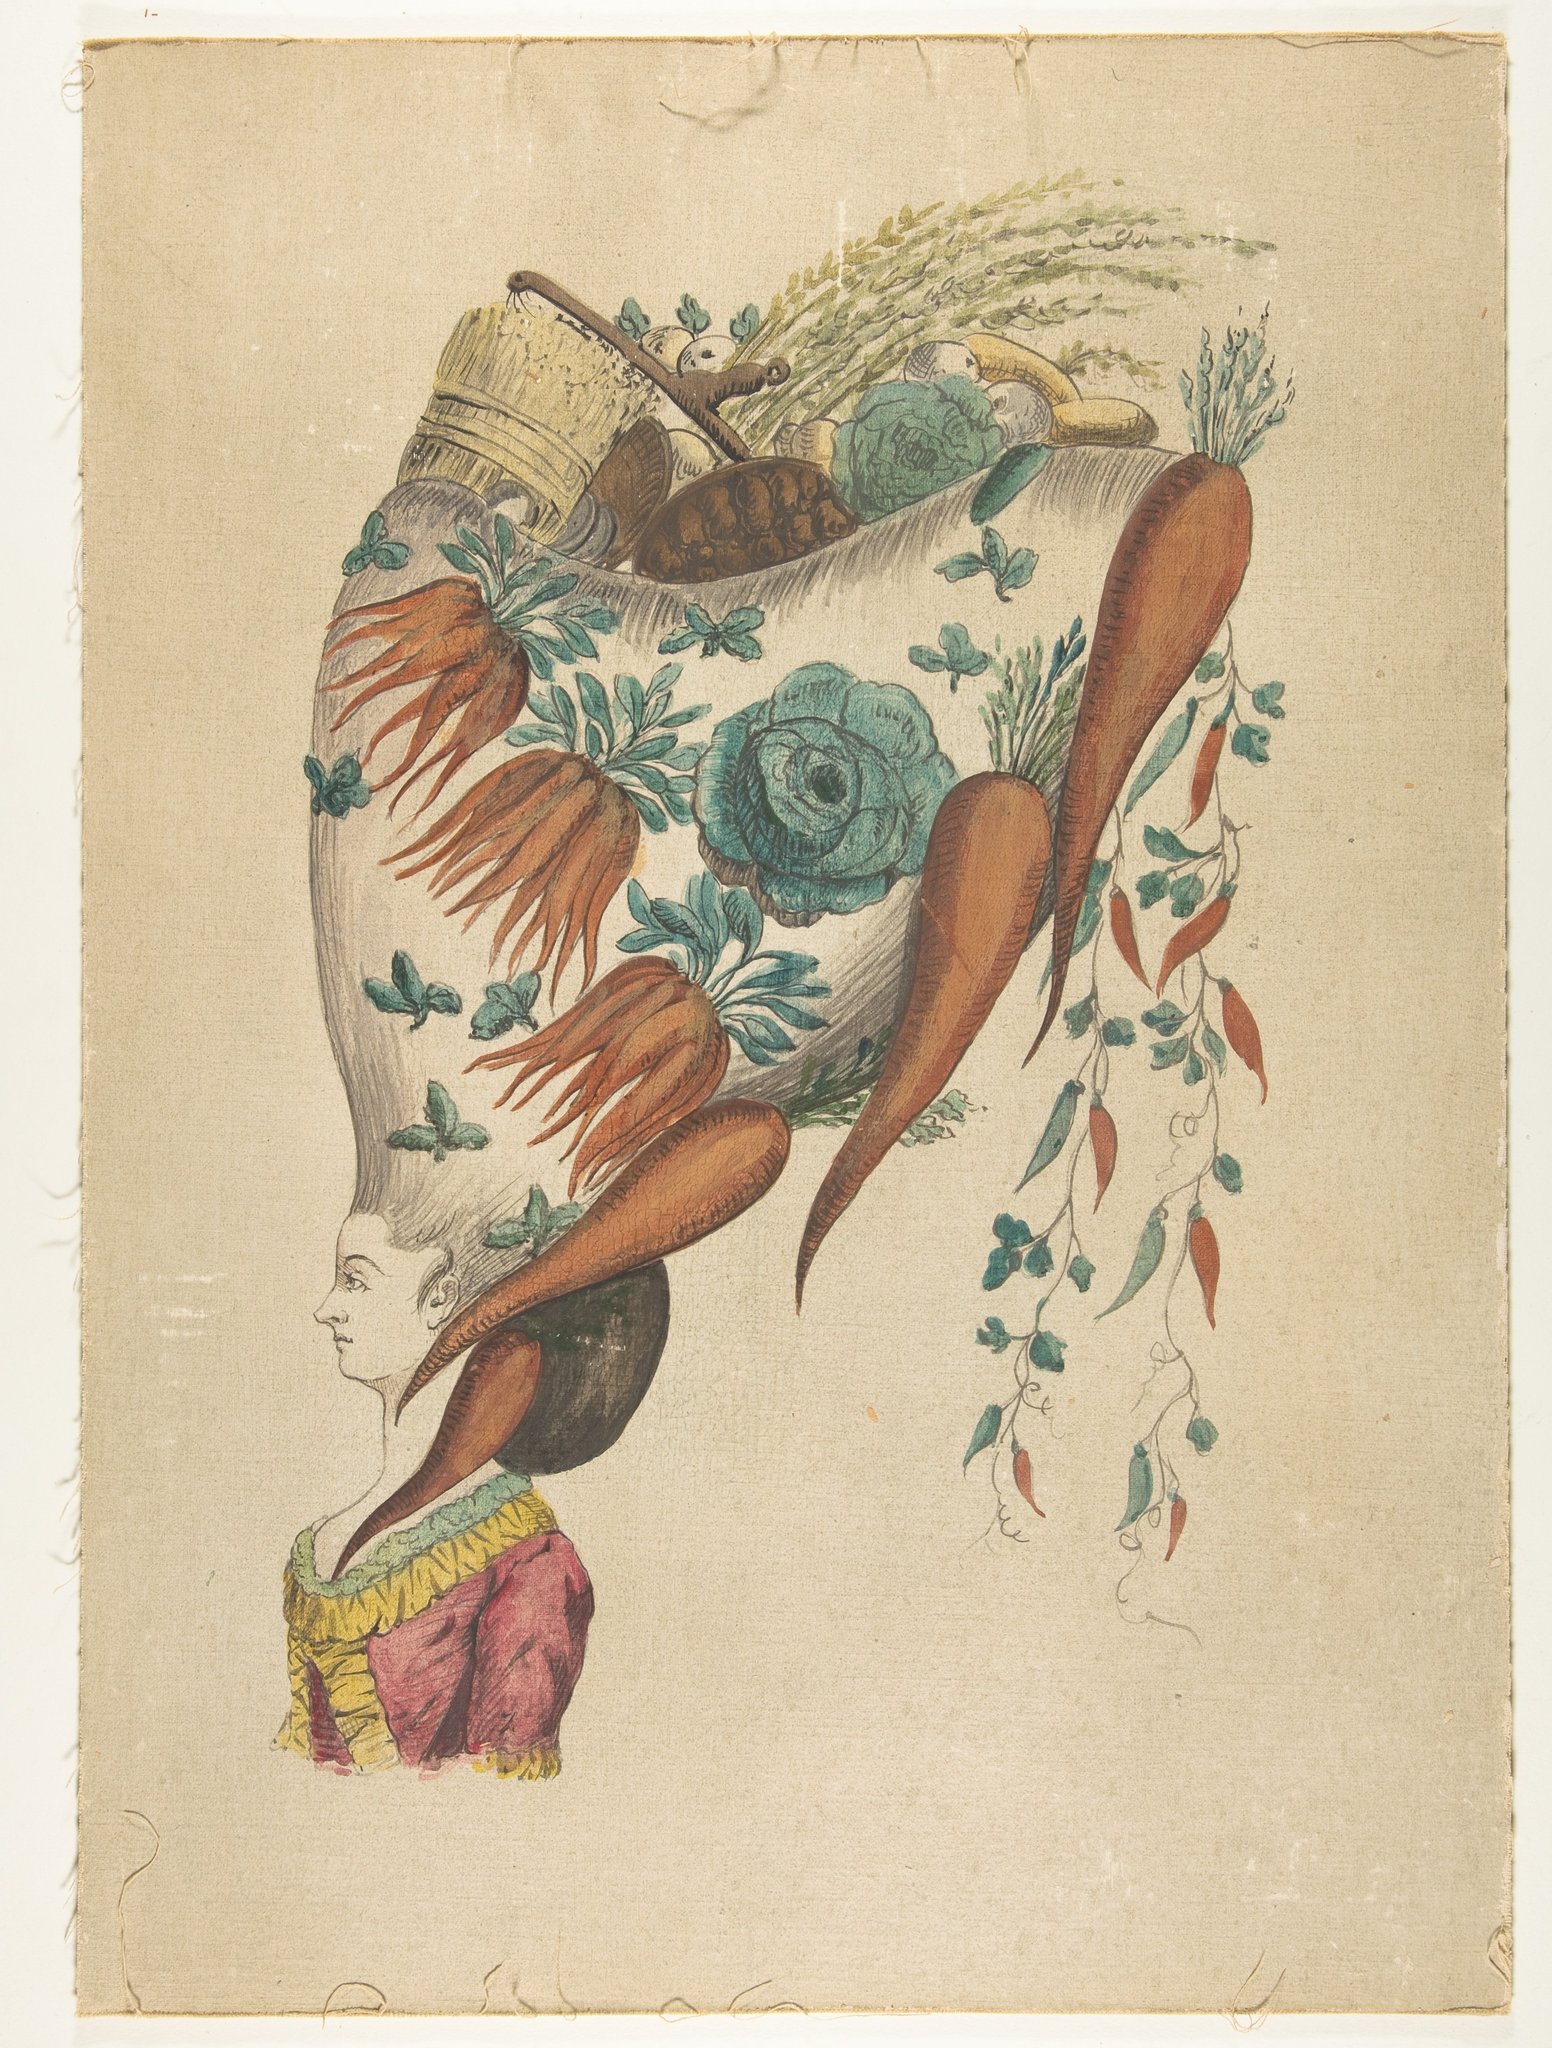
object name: drawing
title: Fantastic Hairdress with Fruit and Vegetable Motif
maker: anonymous, french, 18th century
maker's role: artist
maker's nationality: french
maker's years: 1700-1800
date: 1701-1800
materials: board, canvas, watercolor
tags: carrots,women